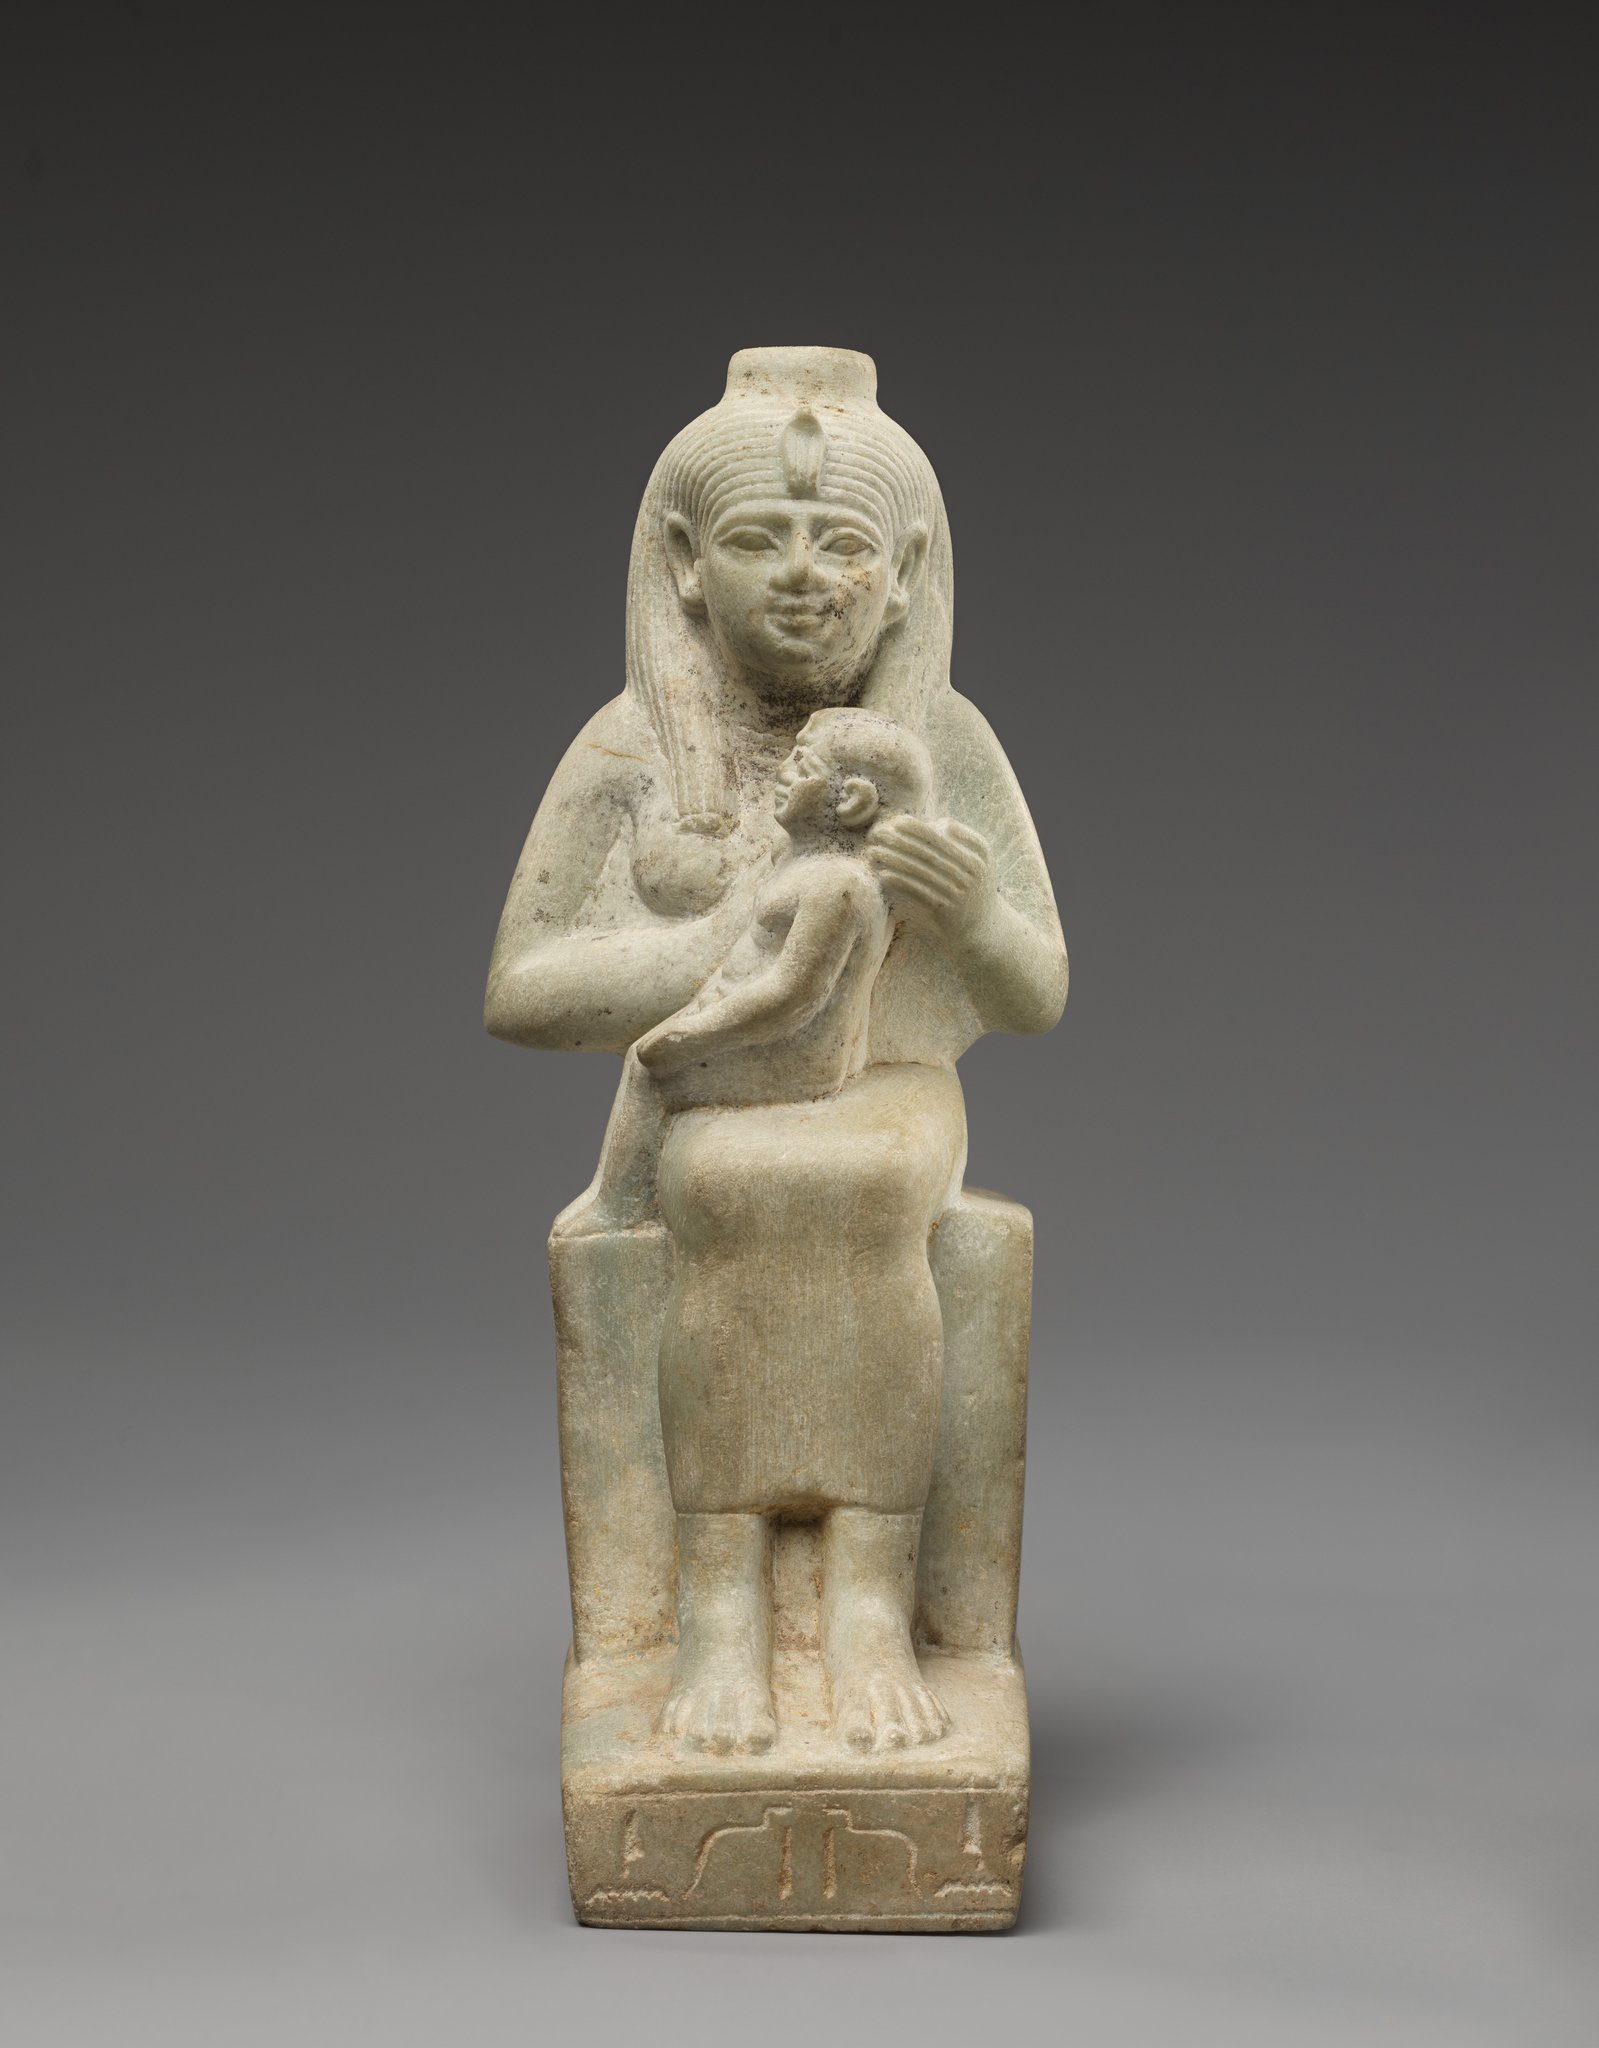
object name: statuette of isi with the horus child, ankhhor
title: Statuette of Isis with the infant Horus, dedicated by Ankhhor, son of Perekhbanebdjedet and Heretib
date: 733-525 BCE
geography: egypt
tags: horus,isis,nursing